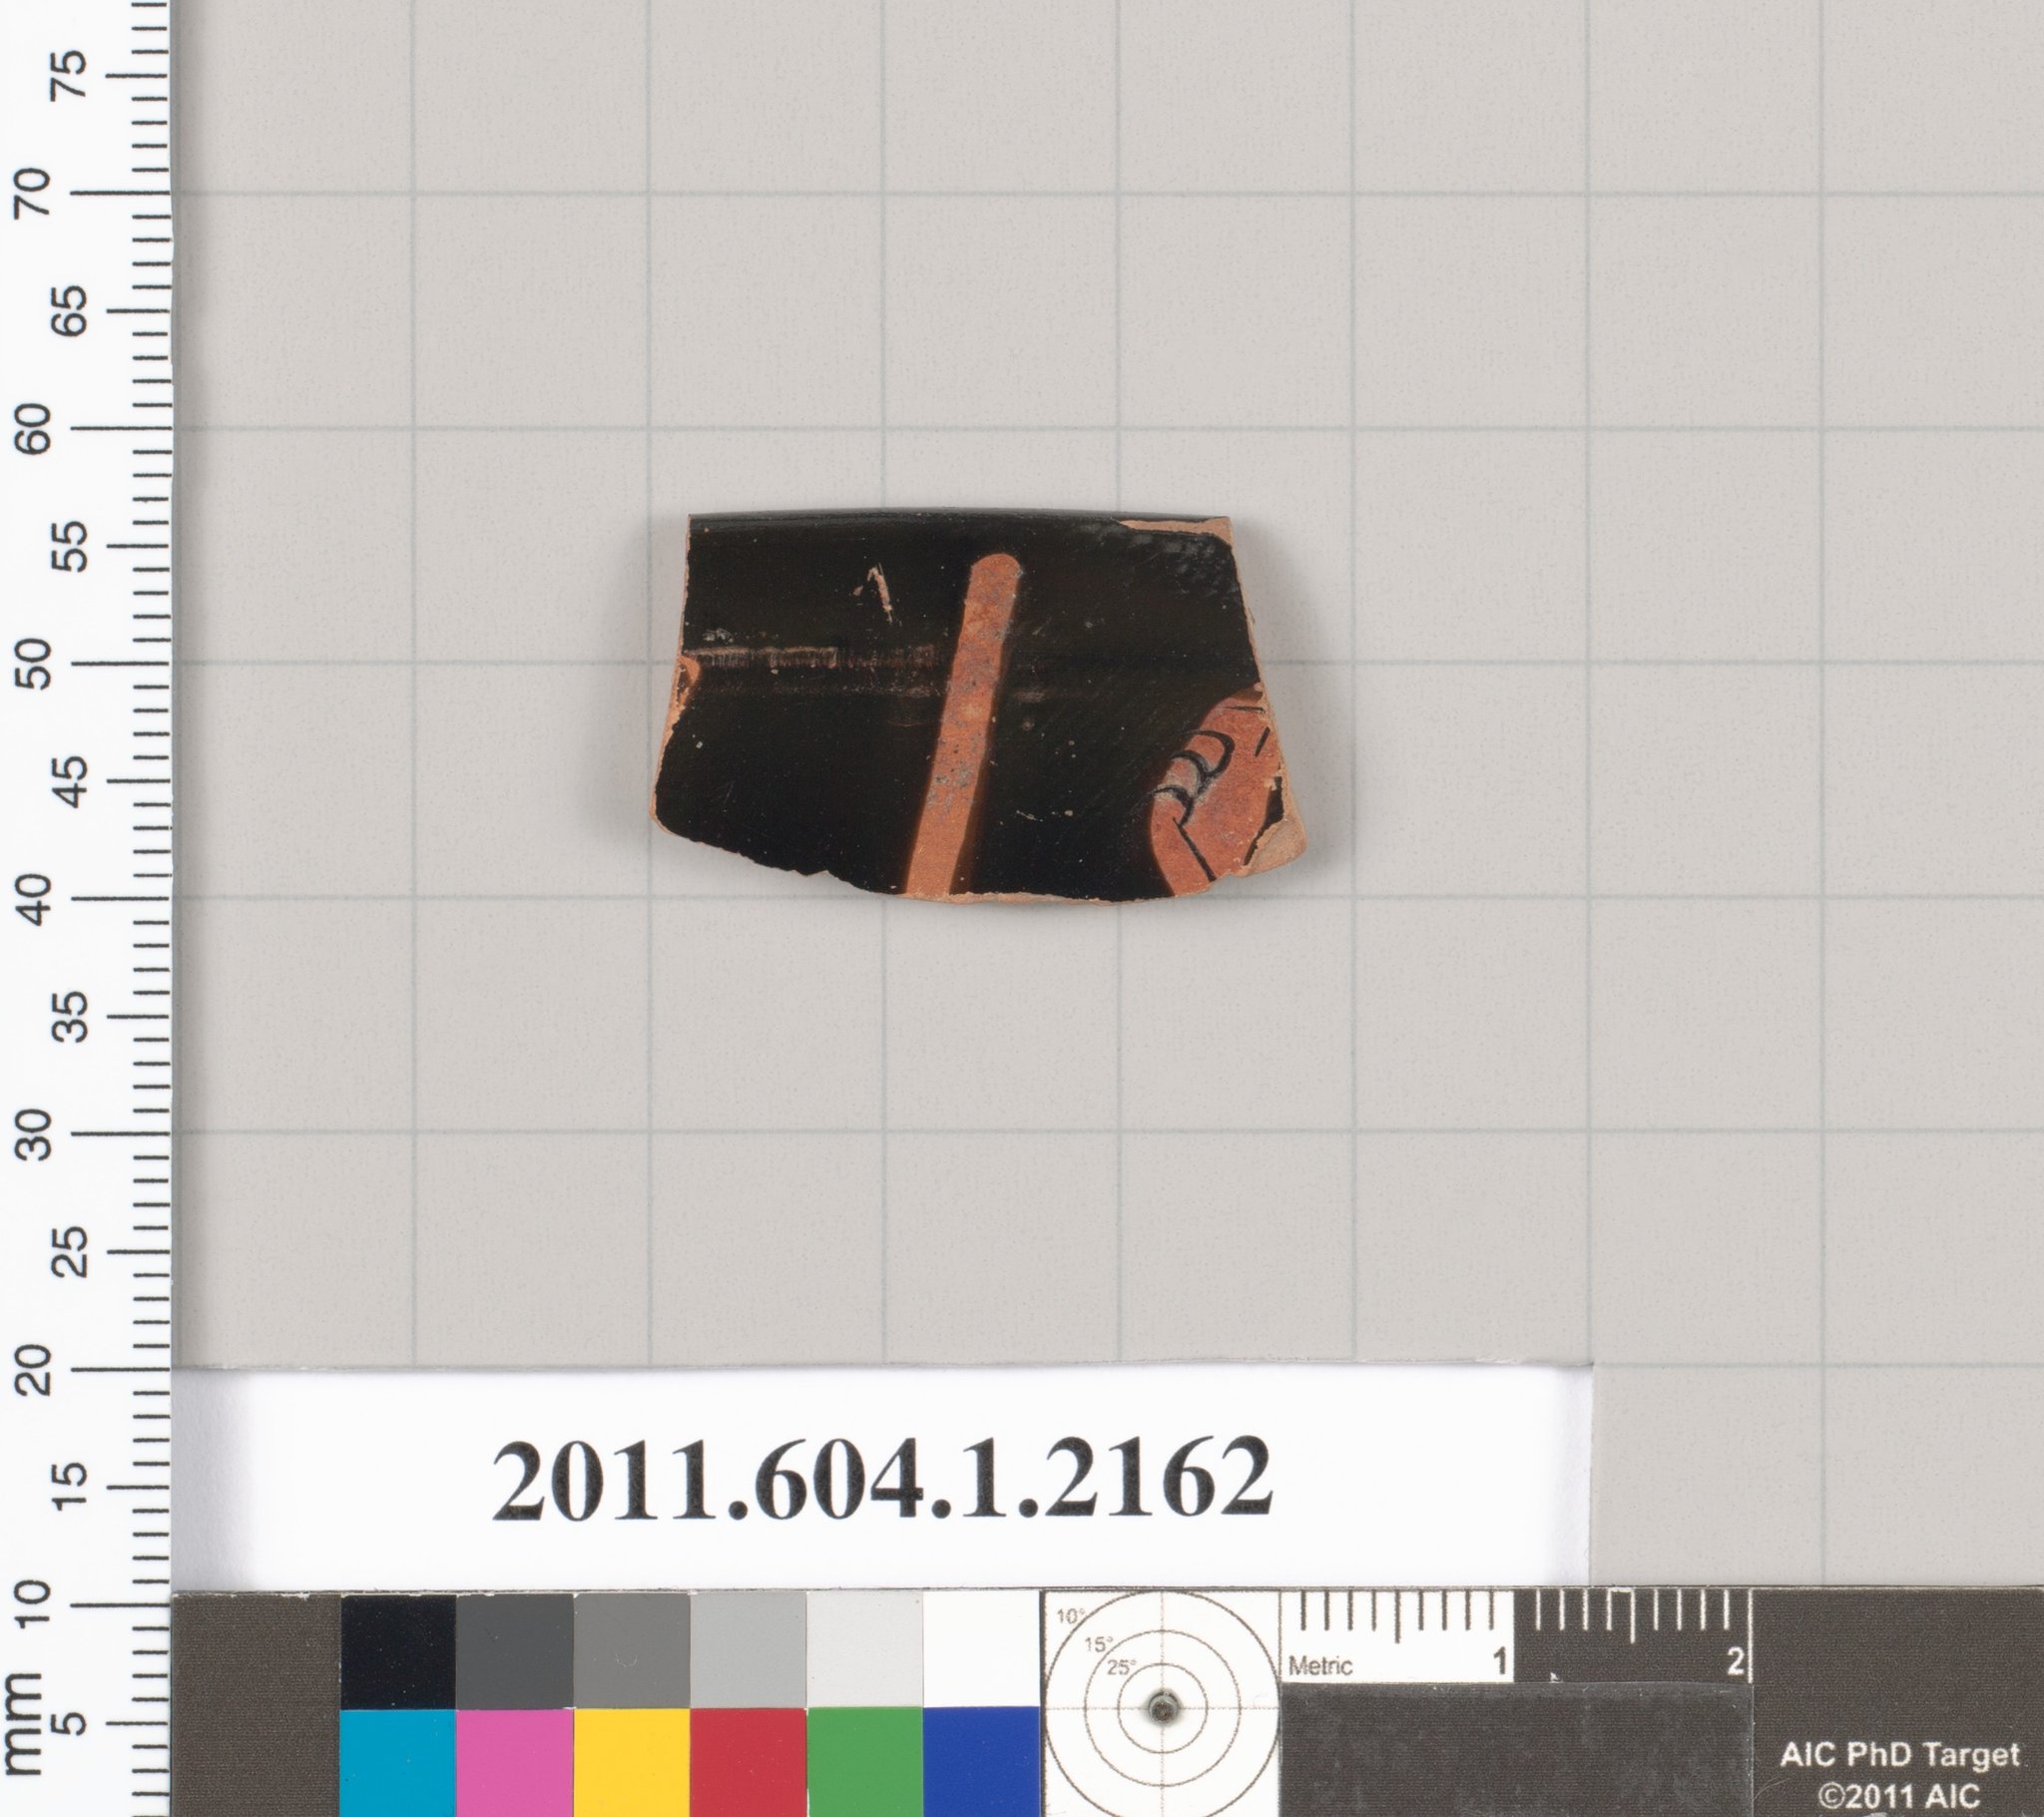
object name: kylix fragment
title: Terracotta rim fragment of a kylix (drinking cup)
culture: greek, attic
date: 500-451 BCE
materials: terracotta